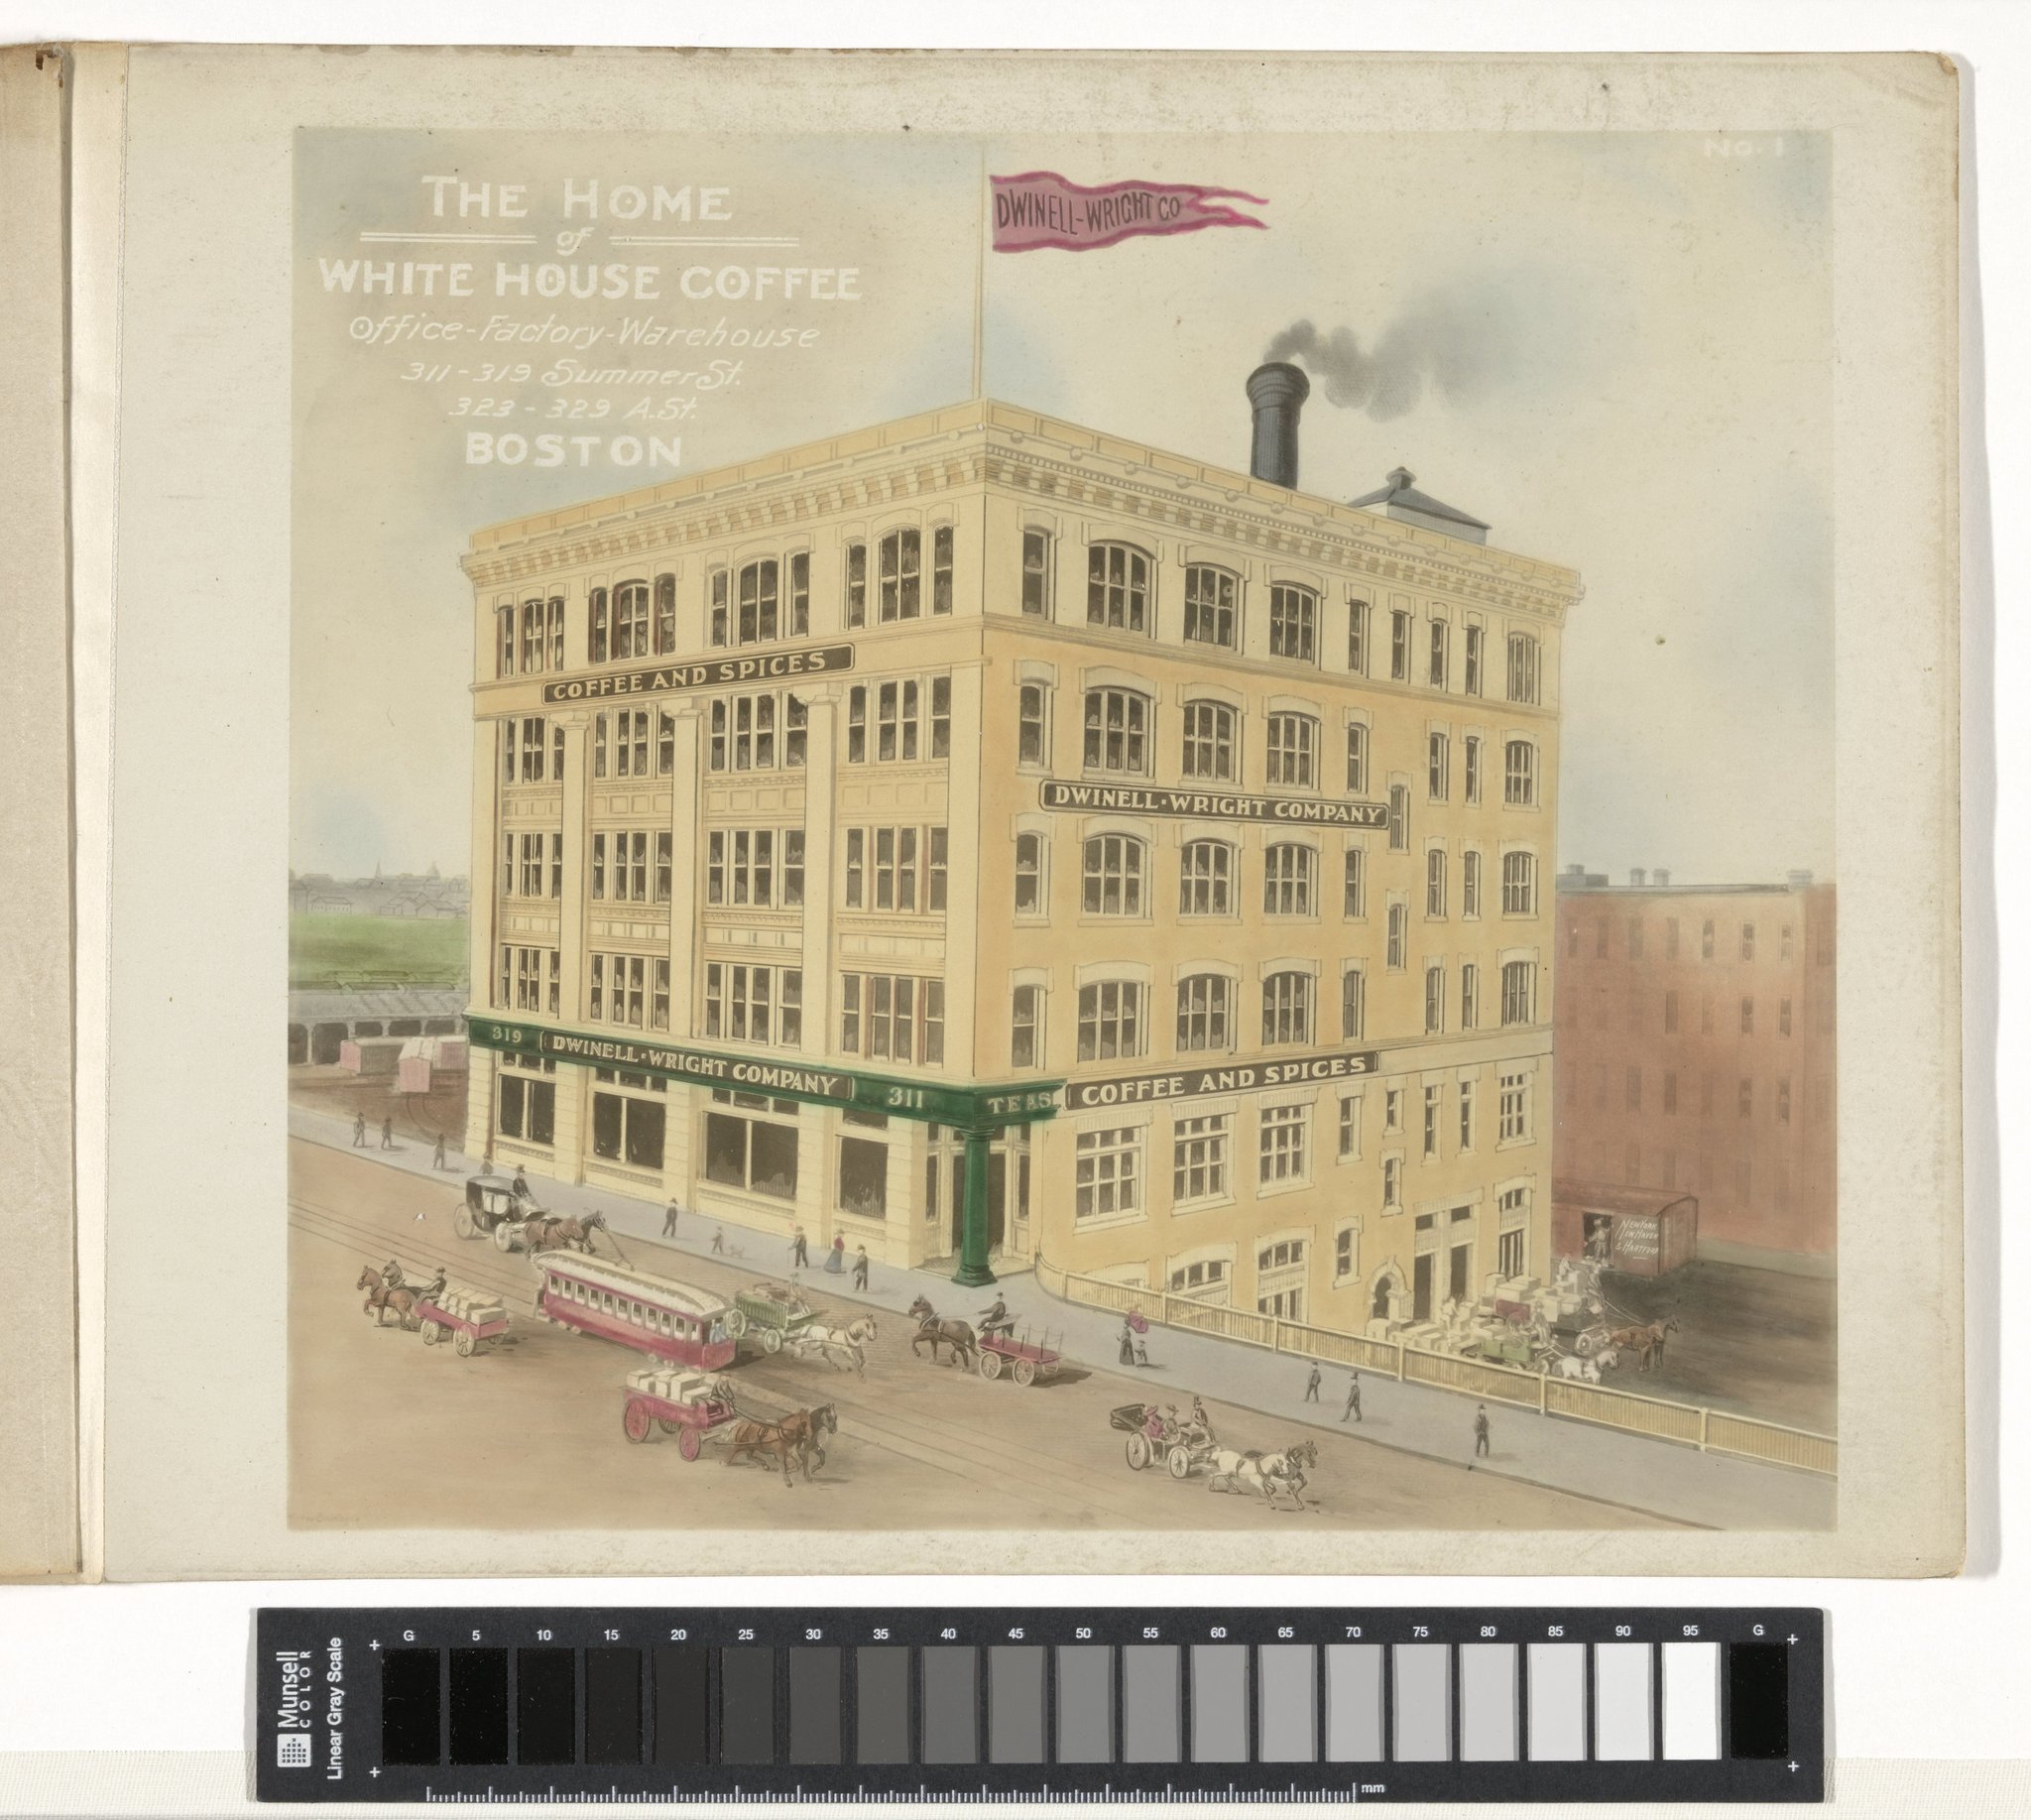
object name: photograph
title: Gezicht op het pand van de Dwinell-Wright Company in Boston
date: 1920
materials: paper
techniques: gelatin silver print, hand coloring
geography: boston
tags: factory-building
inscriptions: number: ‘No. 1’, inscription: ‘The Home/ of/ WHITE HOUSE COFFEE/ Office-Factory-Warehouse/ 311-319 Summer St./ 323-329 A. St./ BOSTON’, inscription: ‘June 7, 1920/ If found,/ please notify/ John Sheedy/ Oklahoma City/ Okla / Lee [...]’